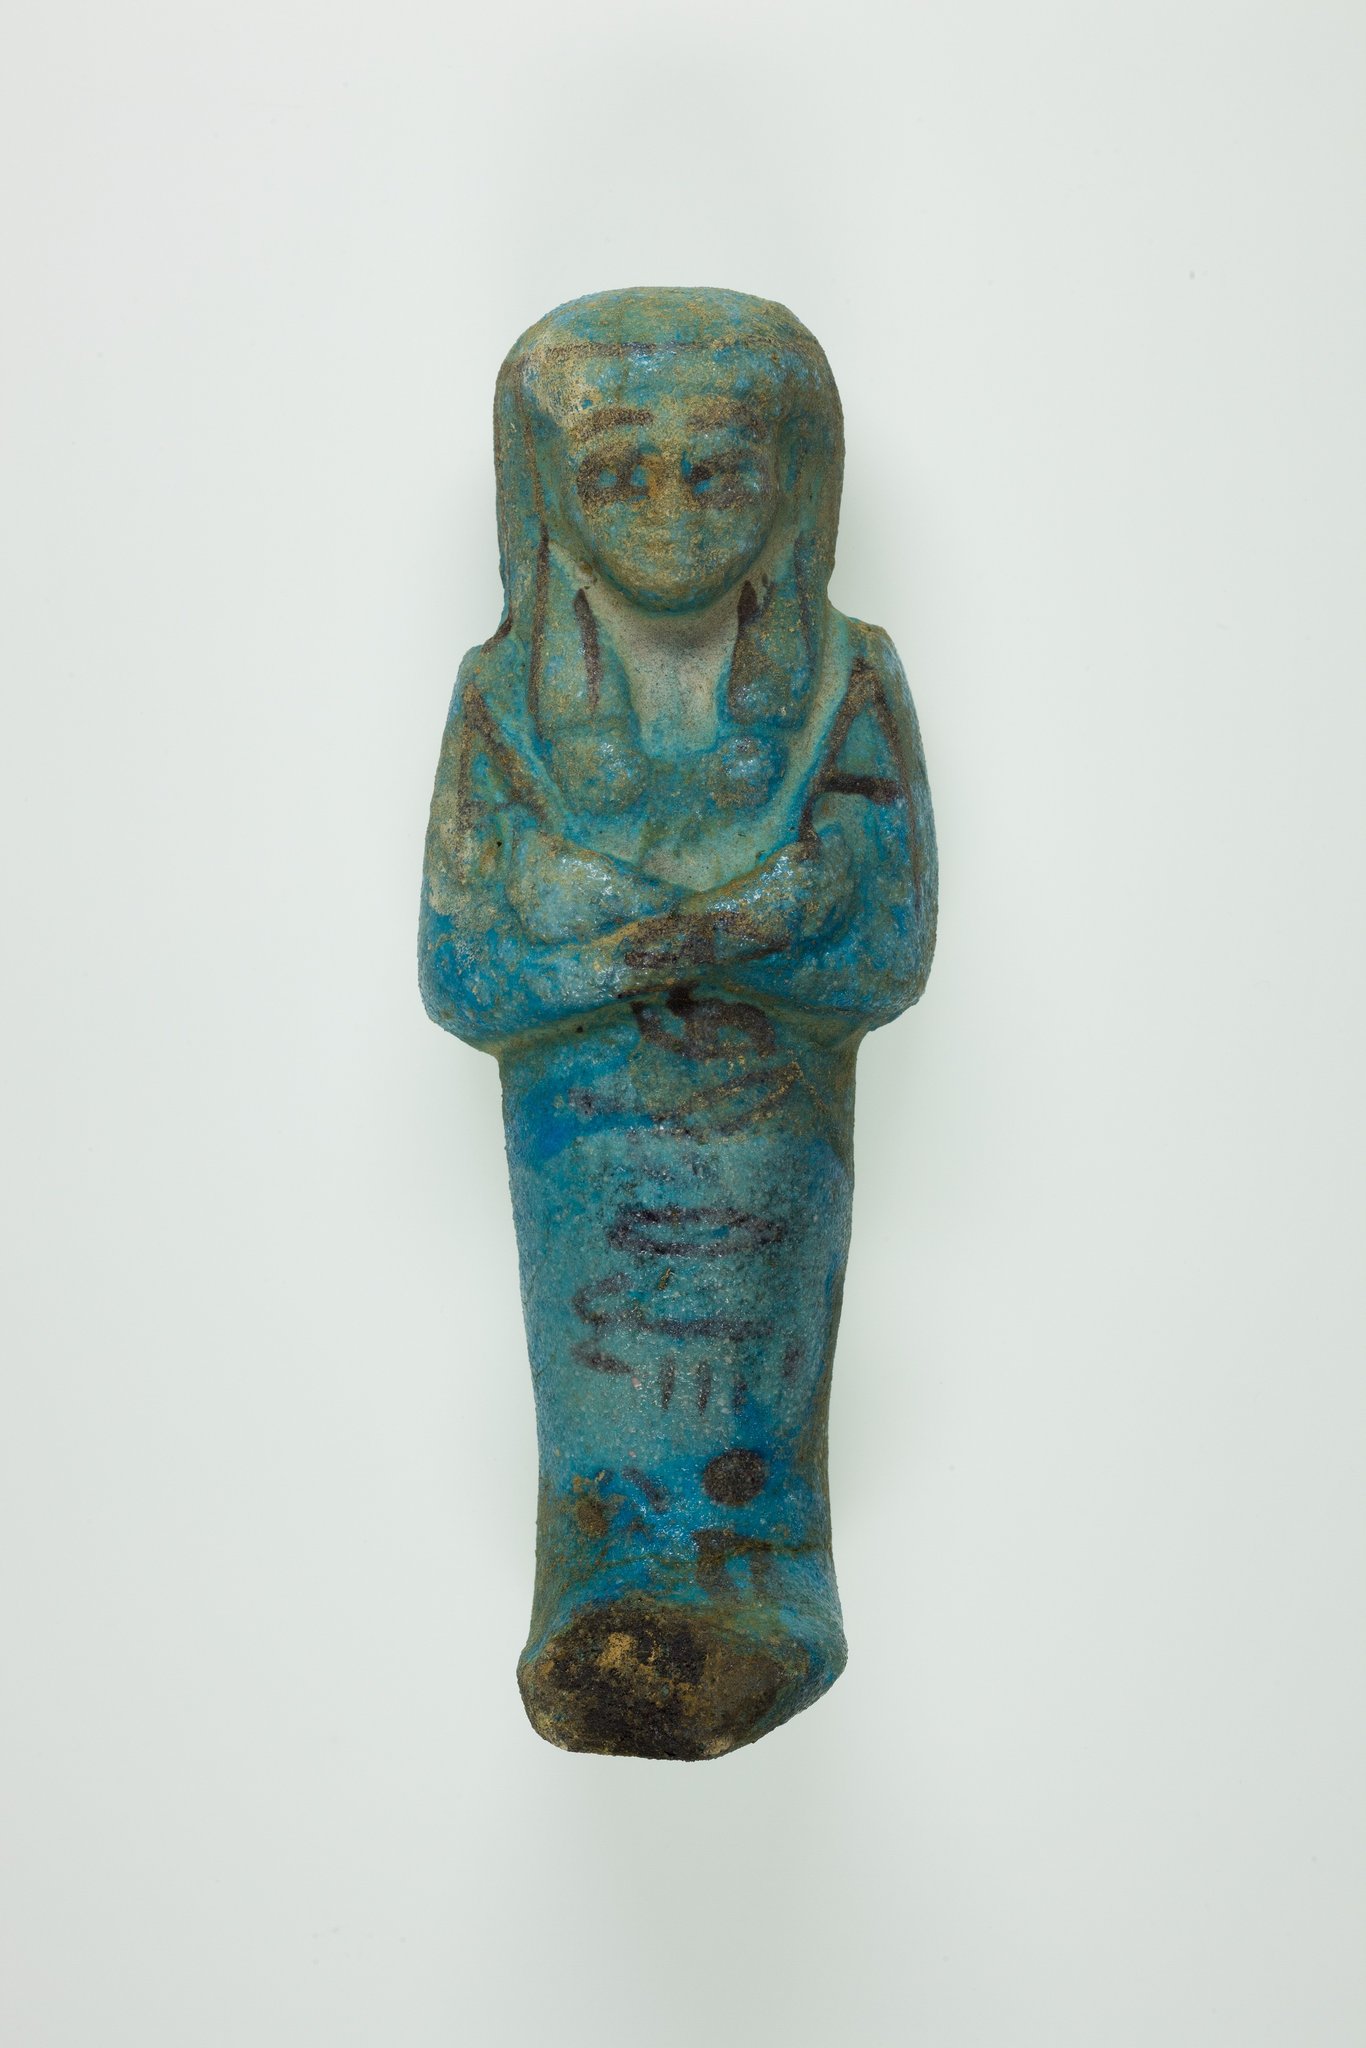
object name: worker shabti, henettawy c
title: Worker Shabti of Henettawy (C), Daughter of Isetemkheb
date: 990-970 BCE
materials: faience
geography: egypt